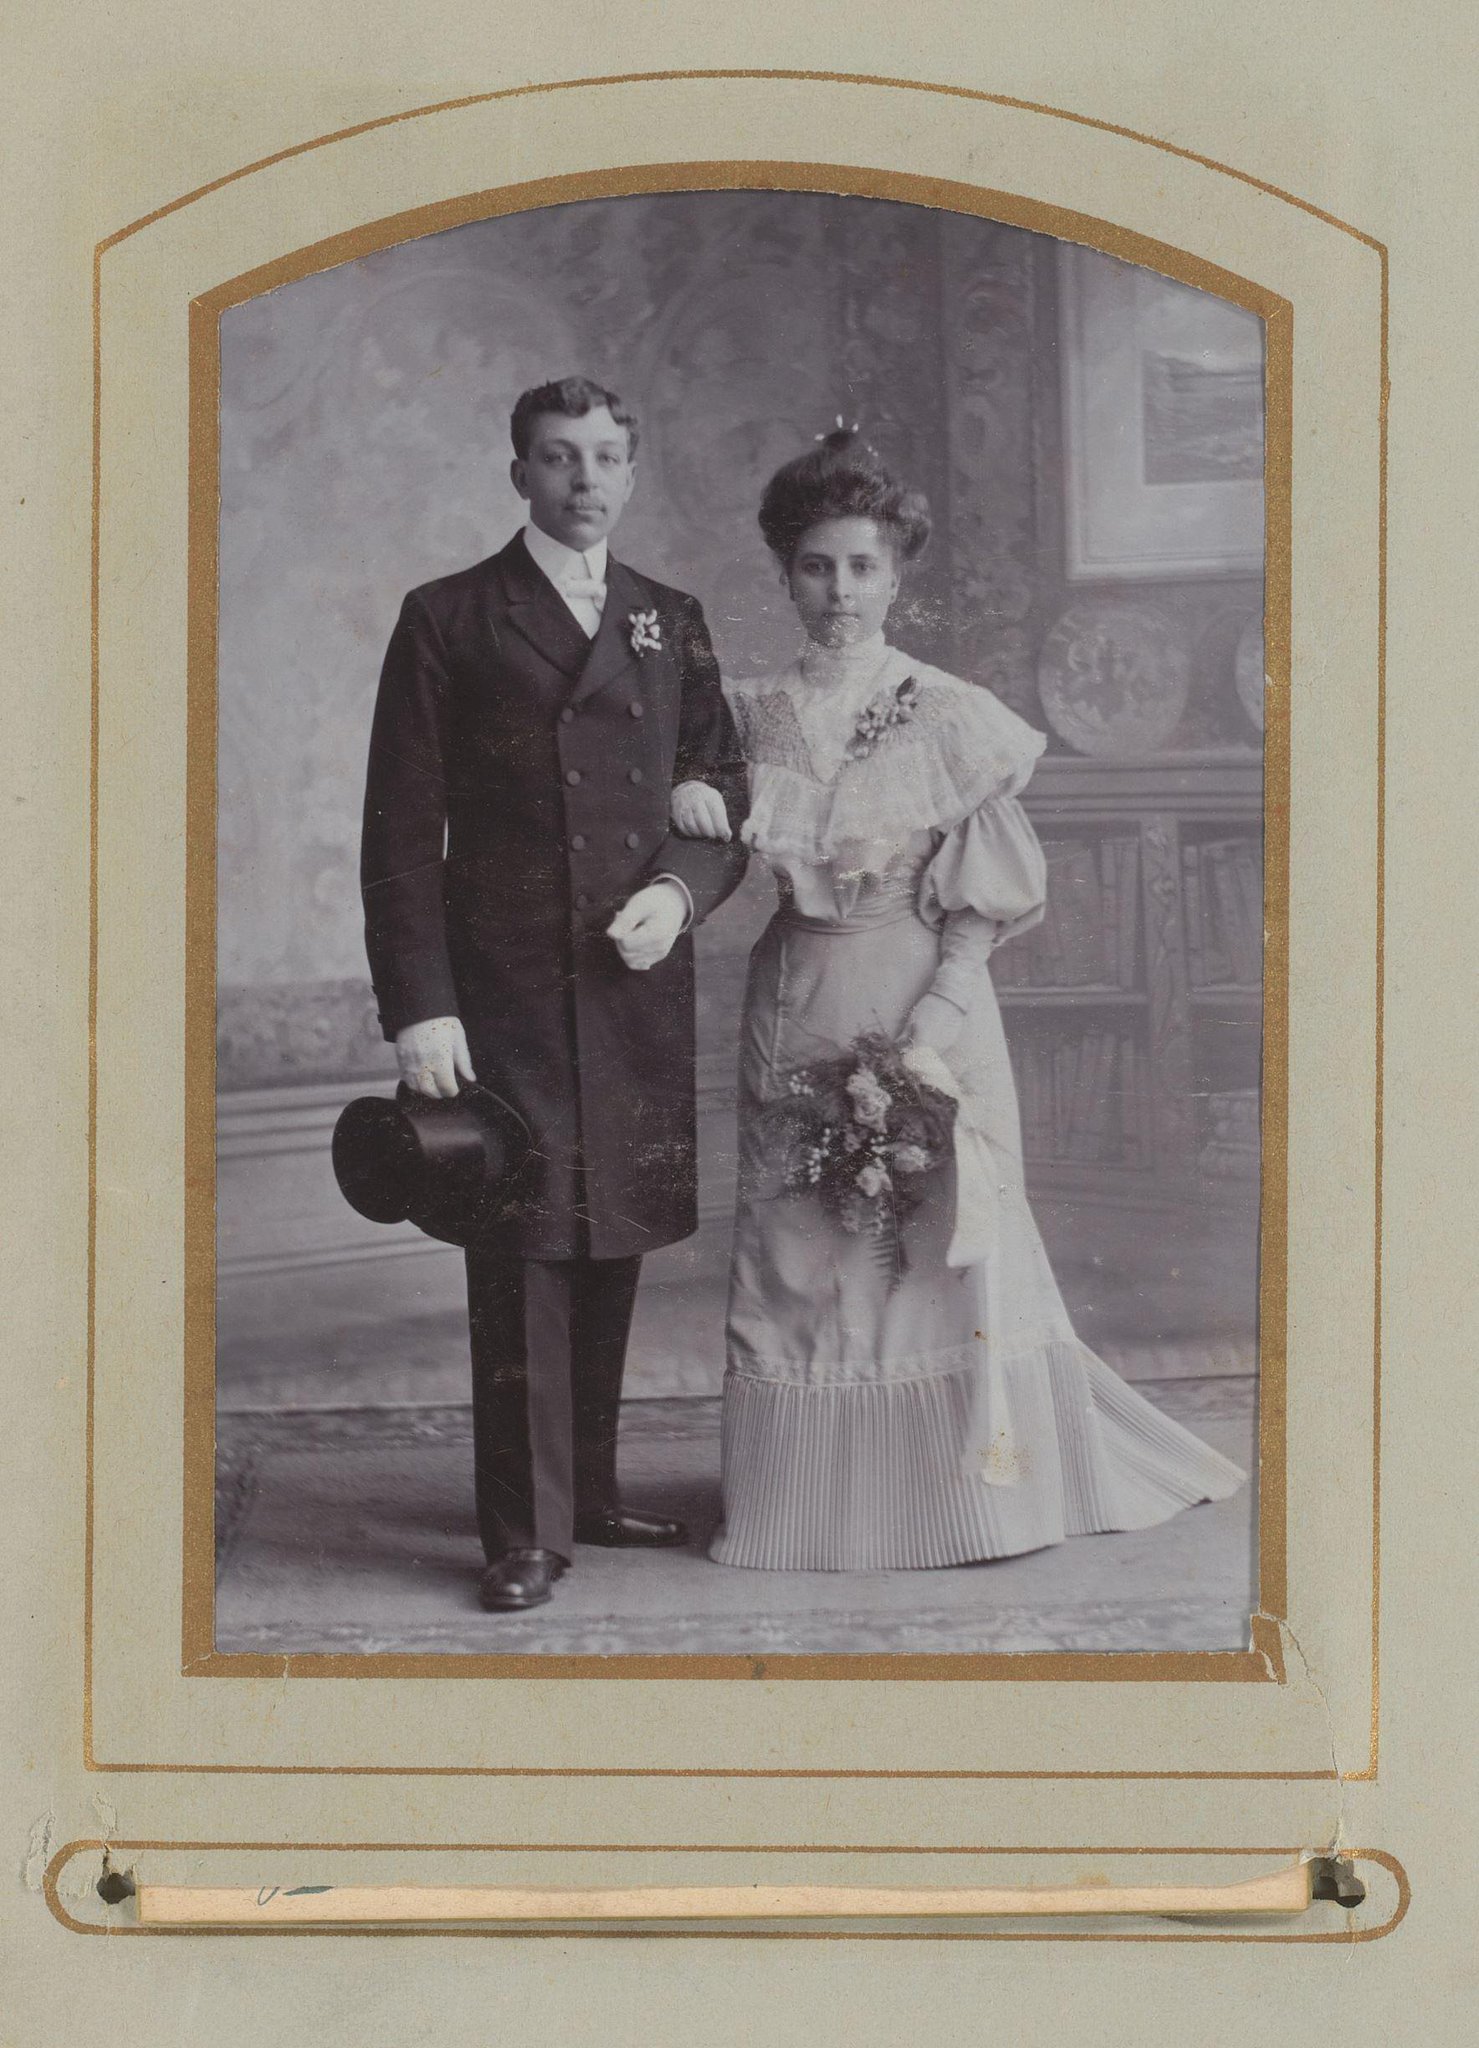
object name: photograph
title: Portret van een echtpaar in bruidskleding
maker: cornelis johannes lodewicus vermeulen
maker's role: fotograaf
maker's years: 1861-1936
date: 1898-1930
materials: cardboard, photographic support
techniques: collodion silver print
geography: netherlands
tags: bride and groom in wedding-dress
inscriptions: inscription: ‘C.J.L. Vermeulen/ Den Haag/ Toussaintkade 11/ Utrecht/ Nieuwe gracht 50’